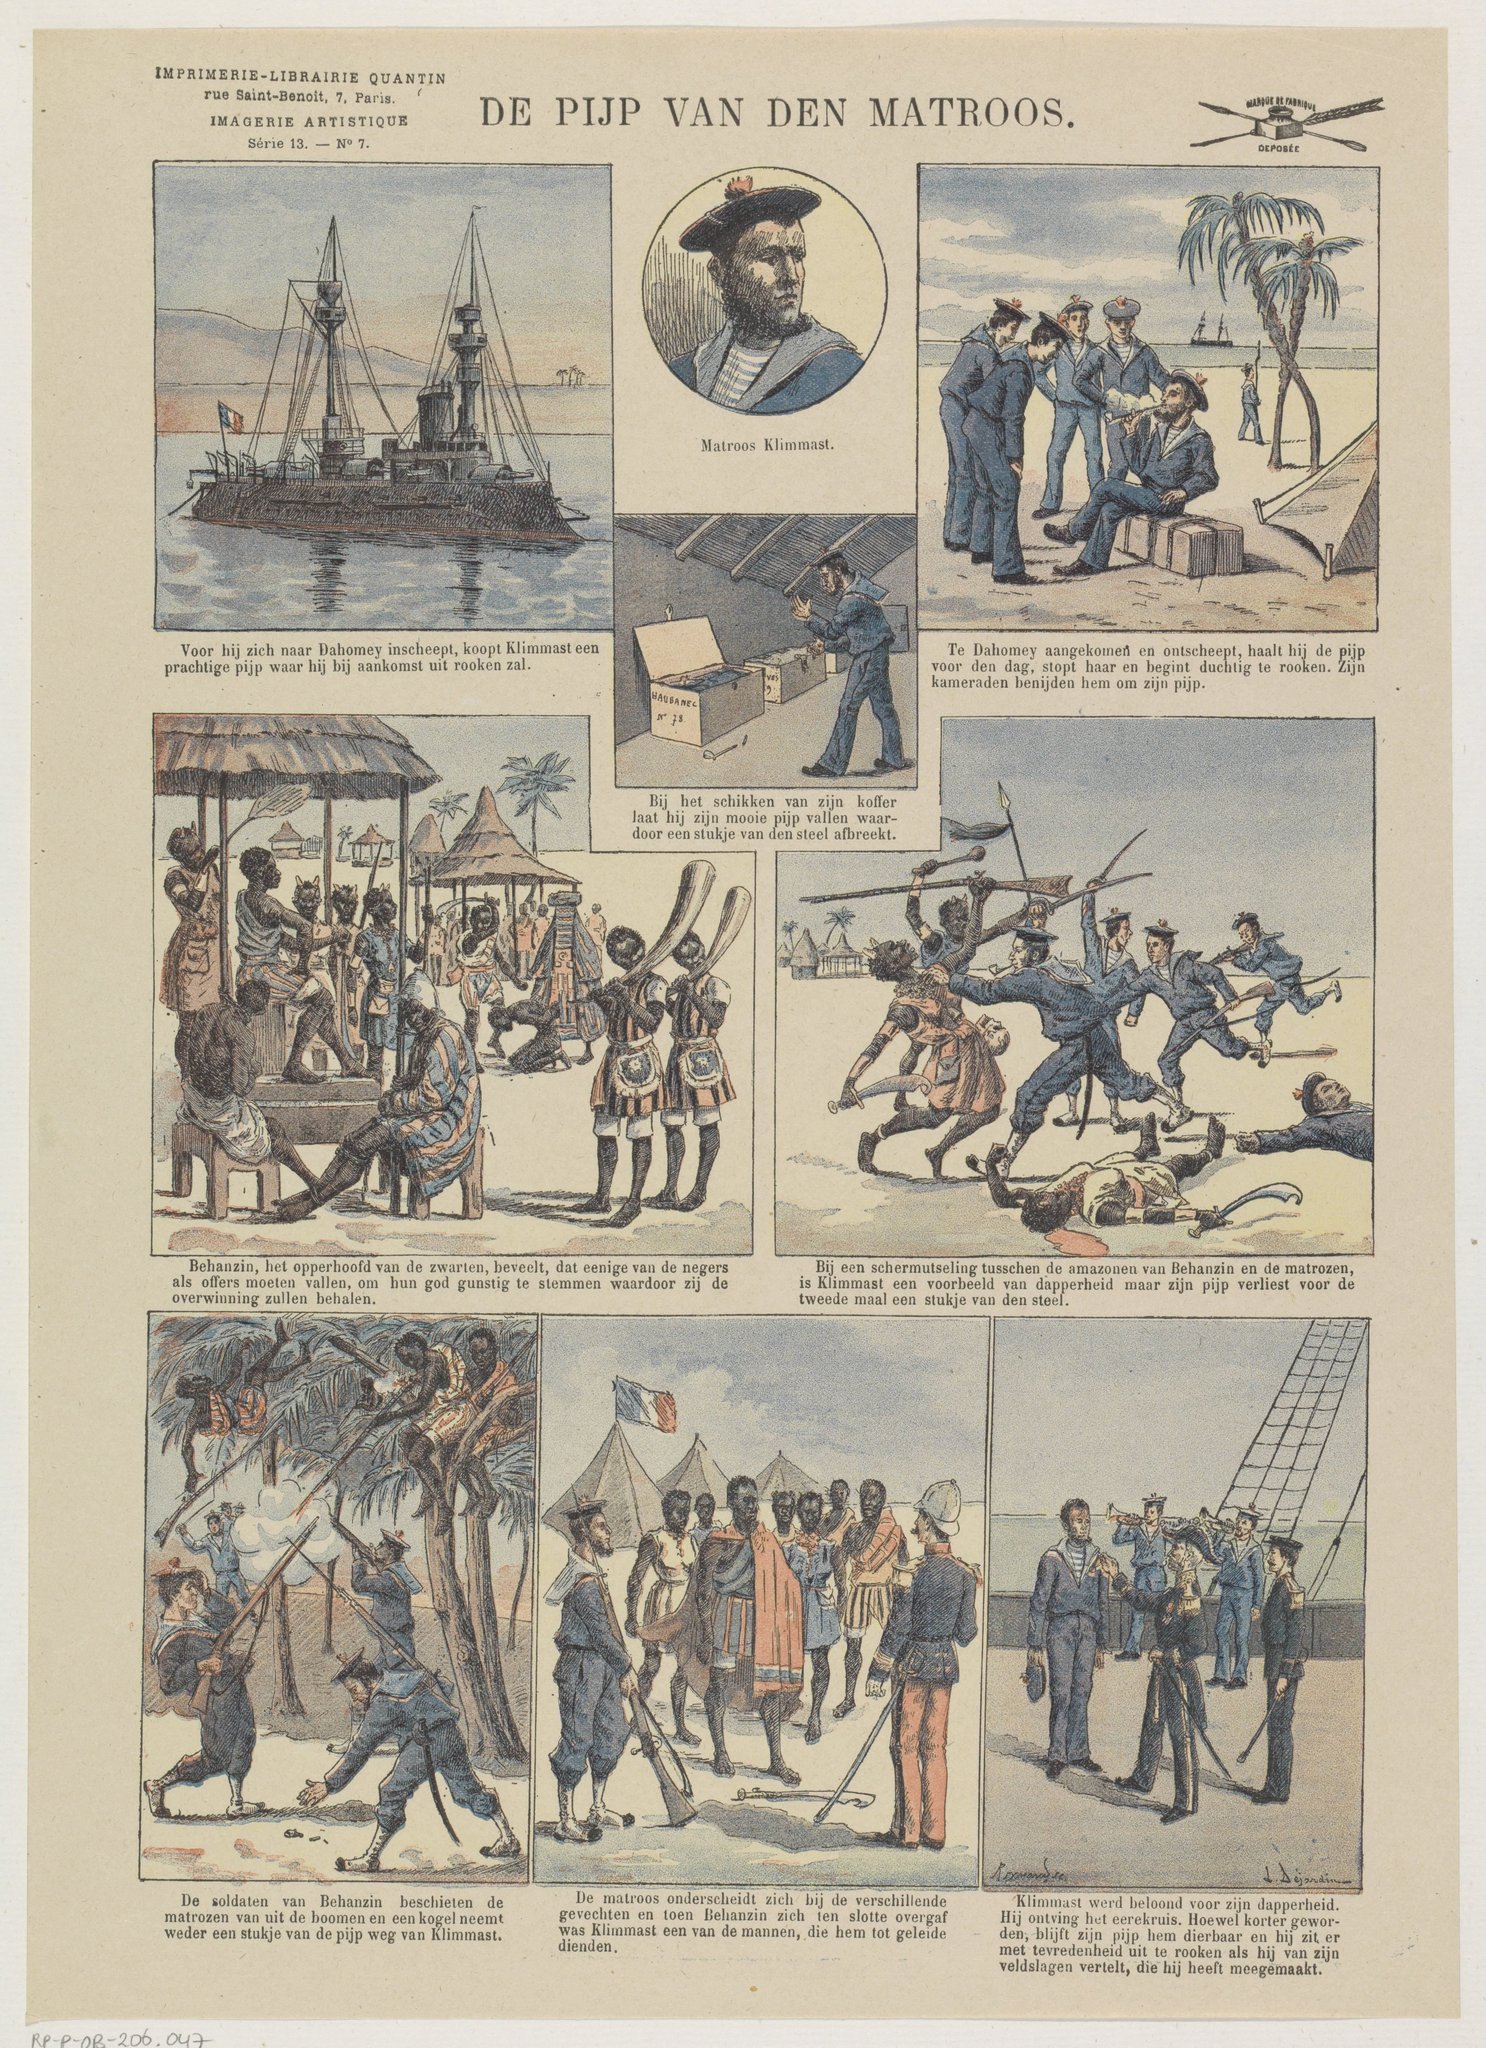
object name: print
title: Imagerie Artistique / Série 13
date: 1876-1890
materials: paper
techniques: lithograph, letterpress printing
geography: paris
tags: pipe ~ tobacco, seaman, tales and fairy tales, seaman: sailor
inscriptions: : ‘marque de fabrique / deposée’, collector's mark: Lugt 2760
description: Blad met 9 voorstellingen van matroos Klimmast en zijn pijp. Onder elke afbeelding een onderschrift. Genummerd linksboven: Série 13. - No. 7.